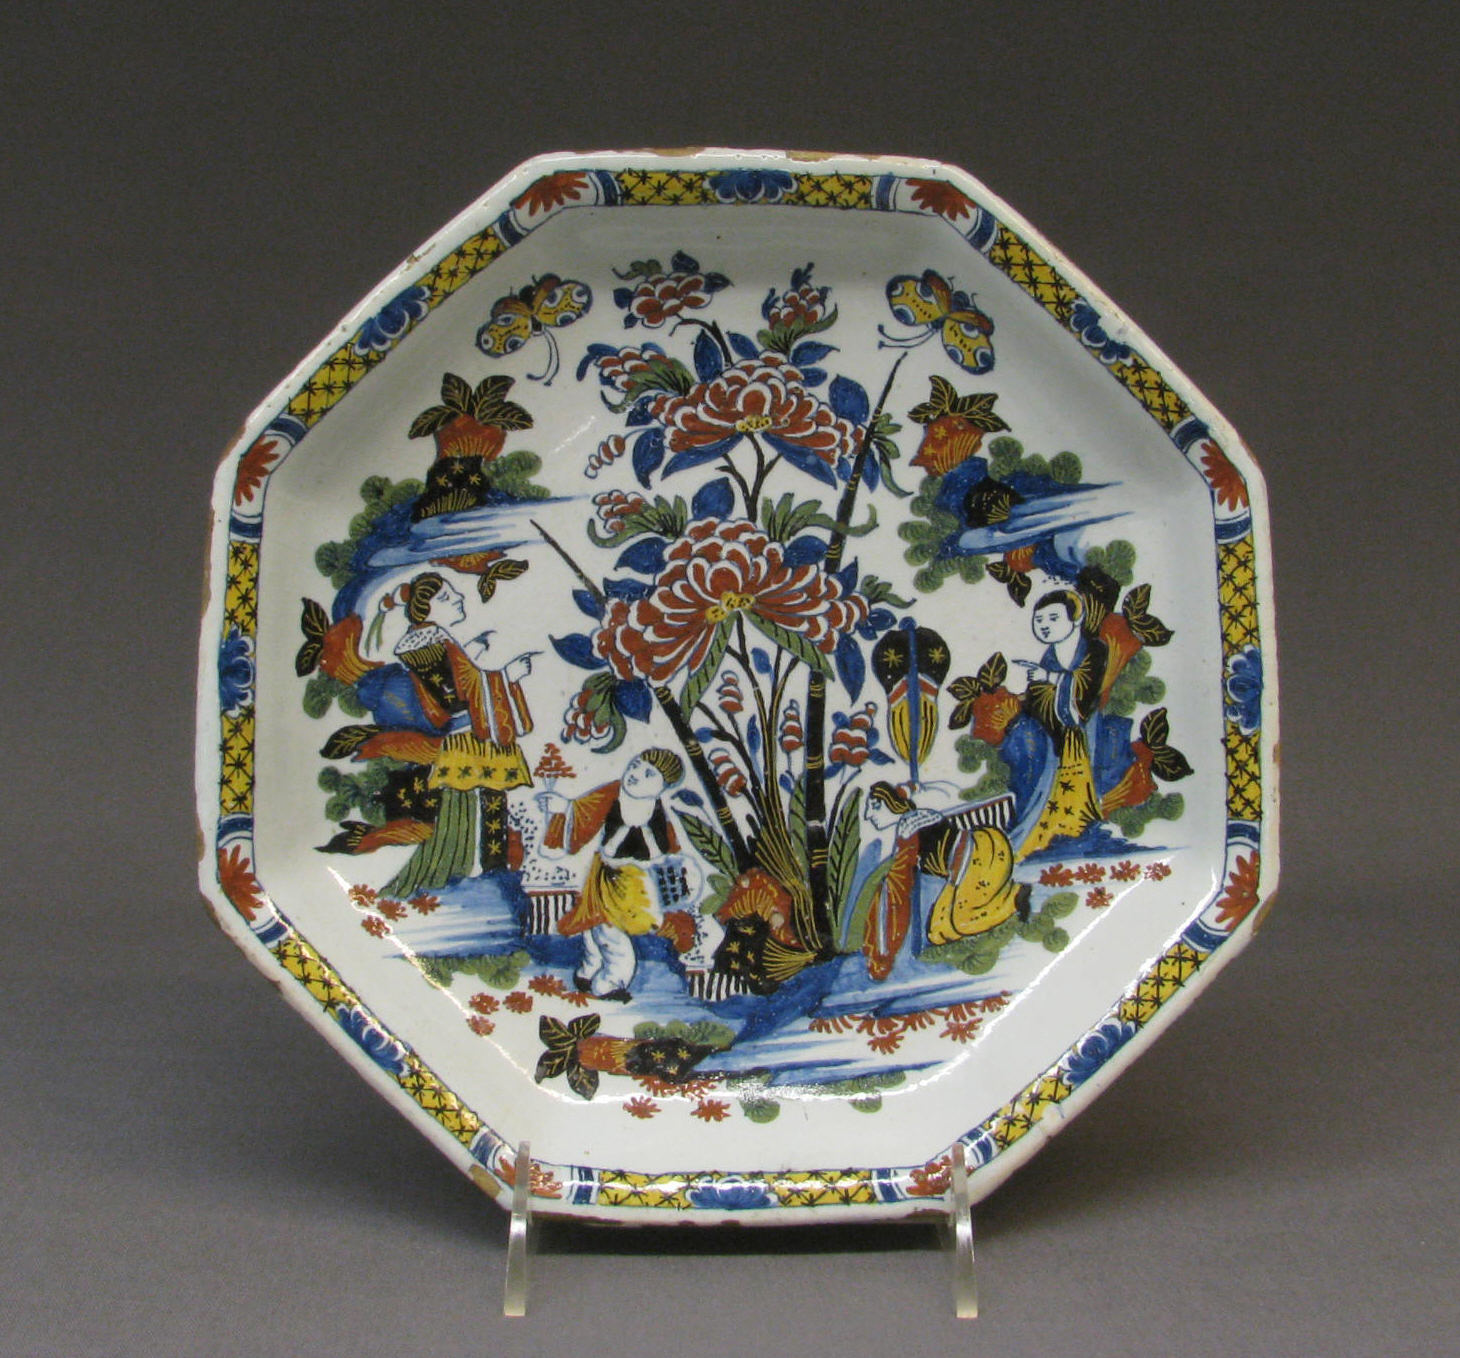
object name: dish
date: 1740-1745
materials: faience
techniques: glazing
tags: men,women,flowers